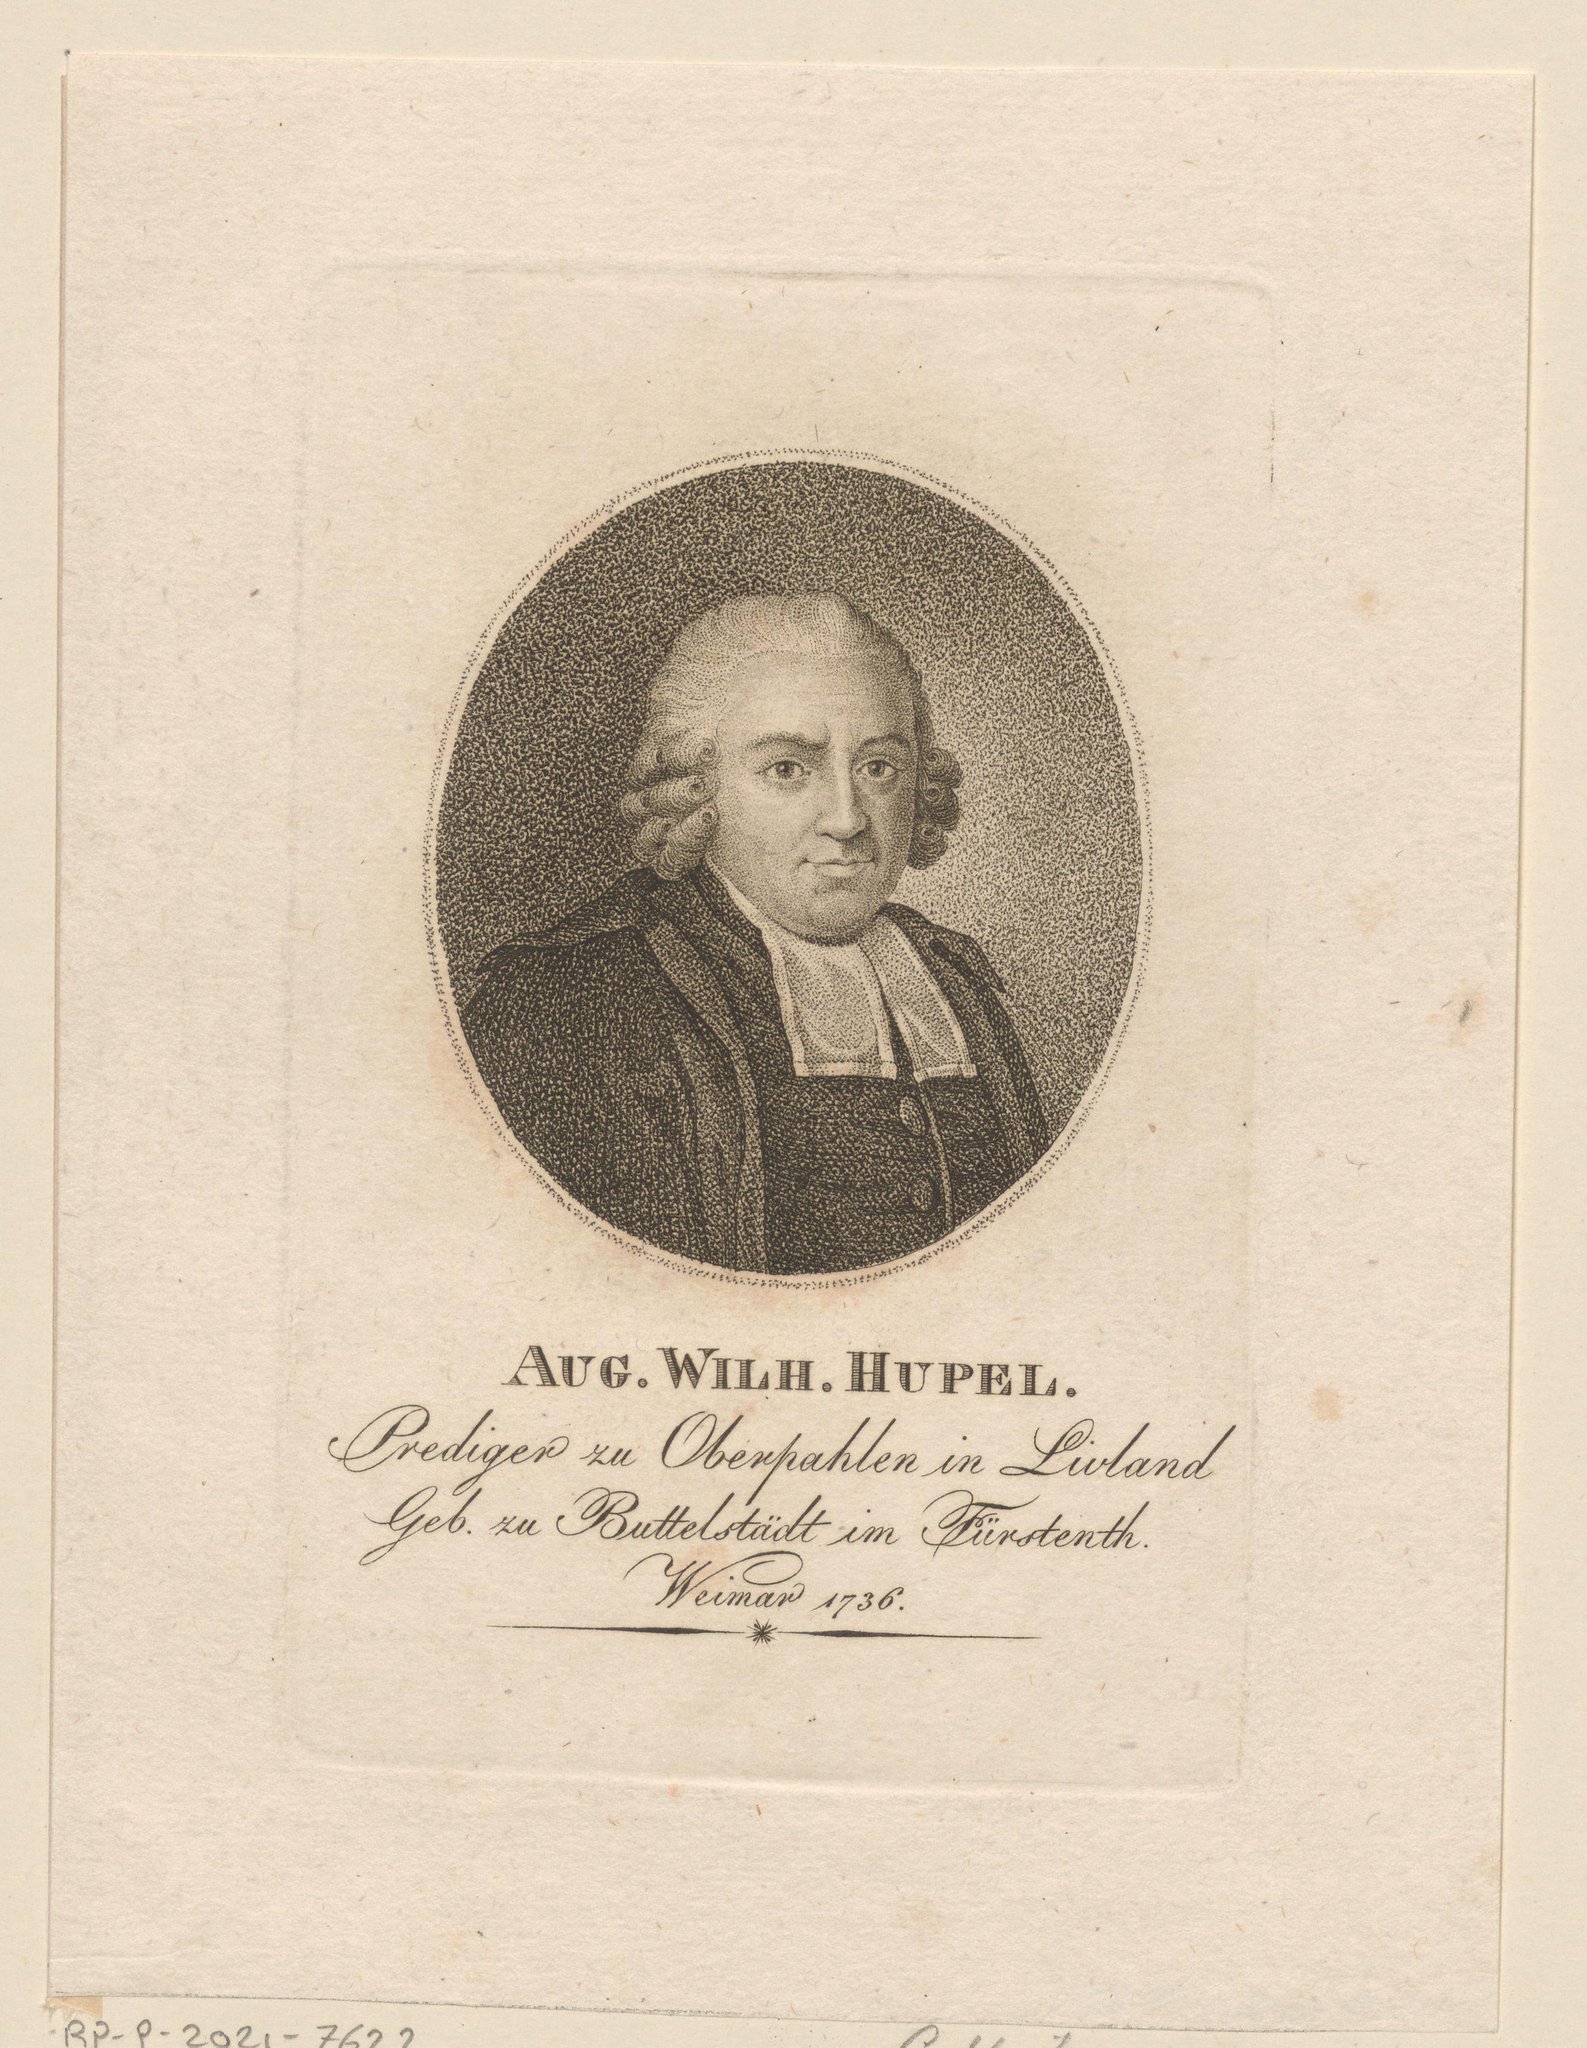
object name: print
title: Portret van August Wilhelm Hupel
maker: Anonymous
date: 1773-1825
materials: paper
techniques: engraving, etching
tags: theologian, historical persons